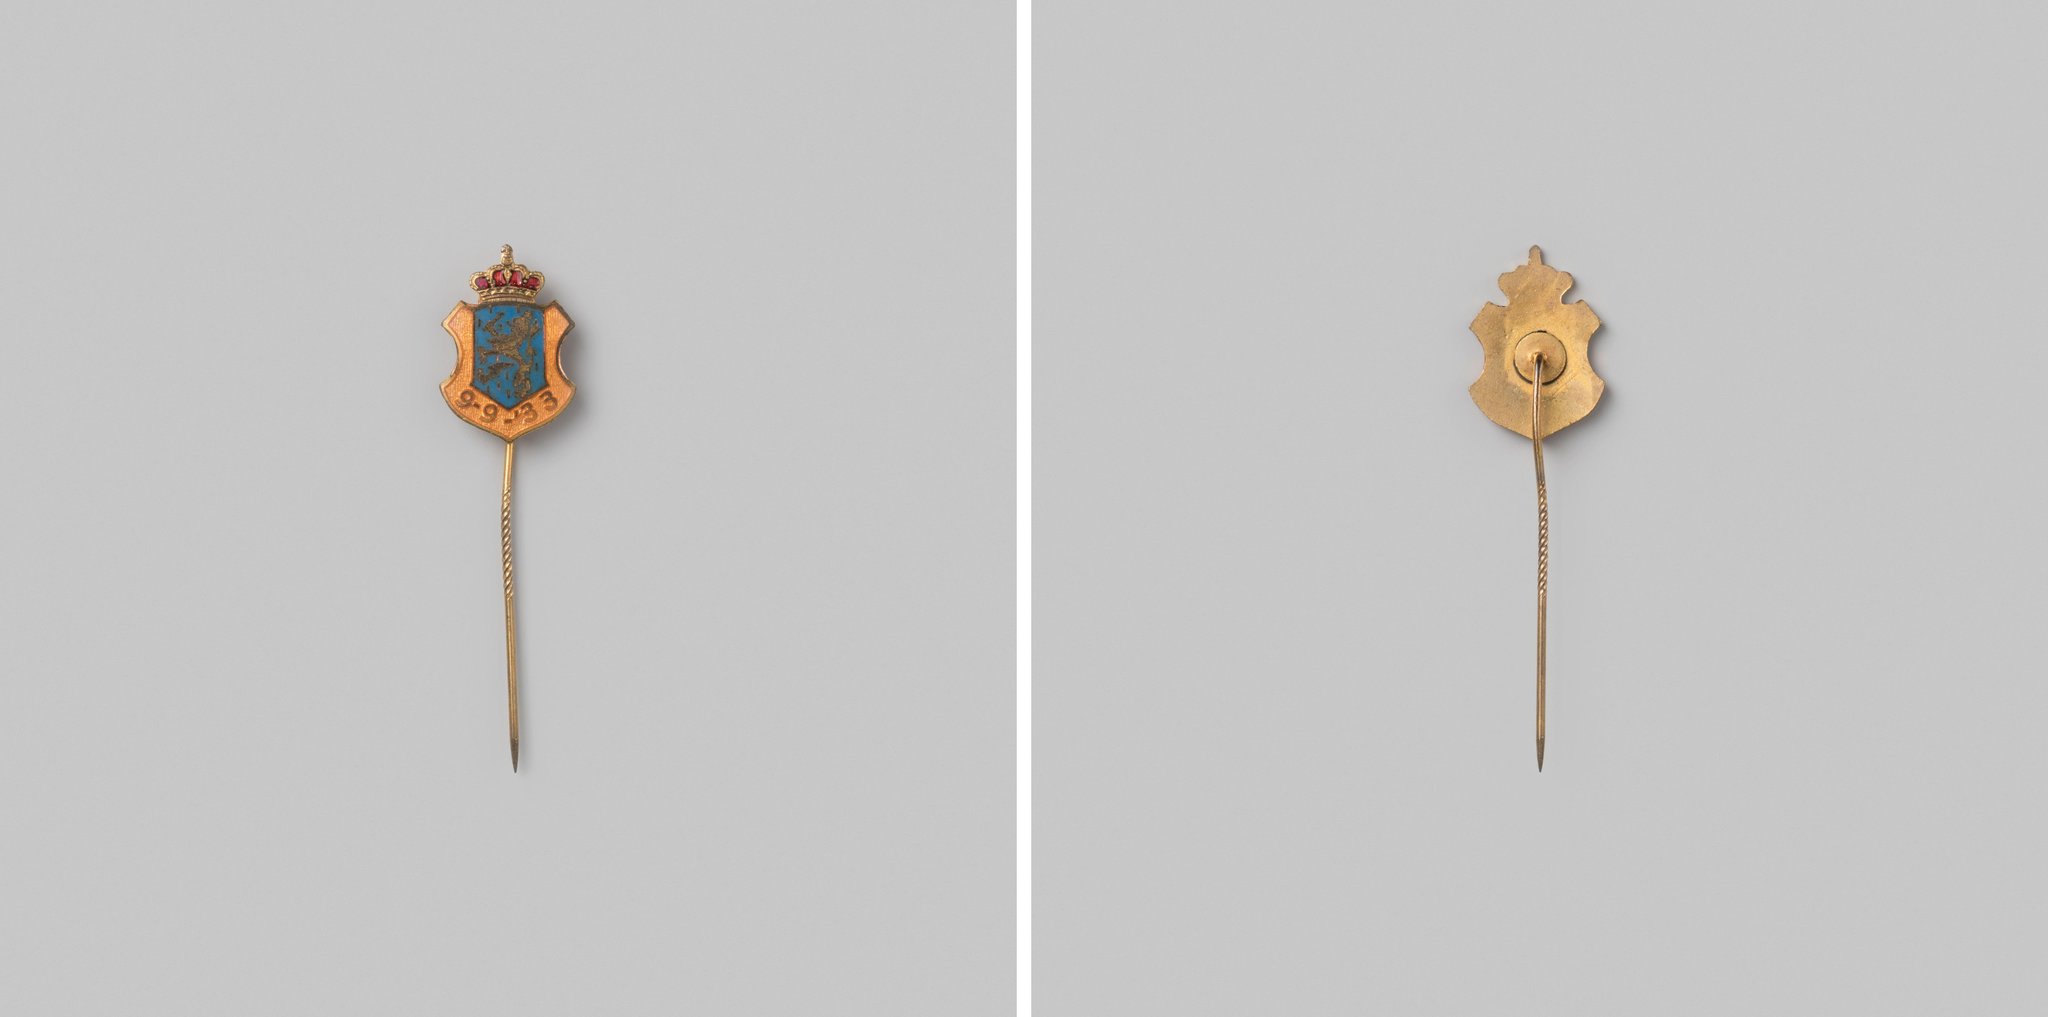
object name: insignia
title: Oranjespeld ter gelegenheid van het 35-jarig regeringsjublileum van H.M. koningin Wilhelmina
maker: Anonymous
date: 1933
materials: metal, paint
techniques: gilding, painting, soldering, striking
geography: netherlands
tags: the hague, print maker, wilhelmina of the netherlands, netherlands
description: Vergulde gekleurde, eenzijdige plaquette, waaraan een speld is bevestigd, waarvan gedeelte is gedraaid. Voorzijde: gekroond wapenschild, boven datering. Keerzijde: blanco